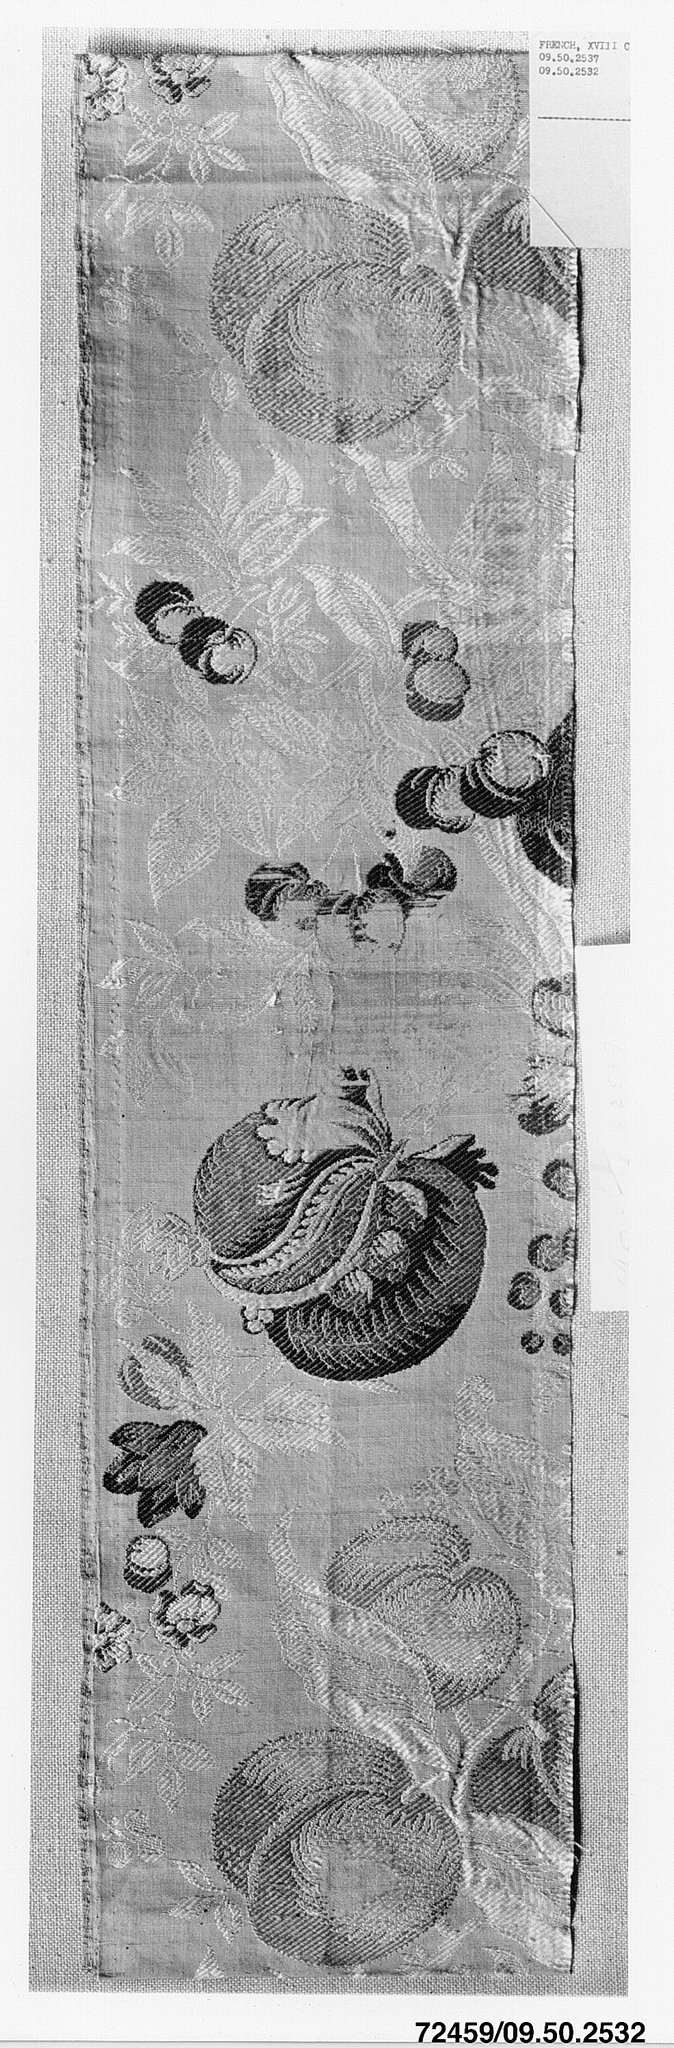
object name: piece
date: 1730-1735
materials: silk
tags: fruit,leaves